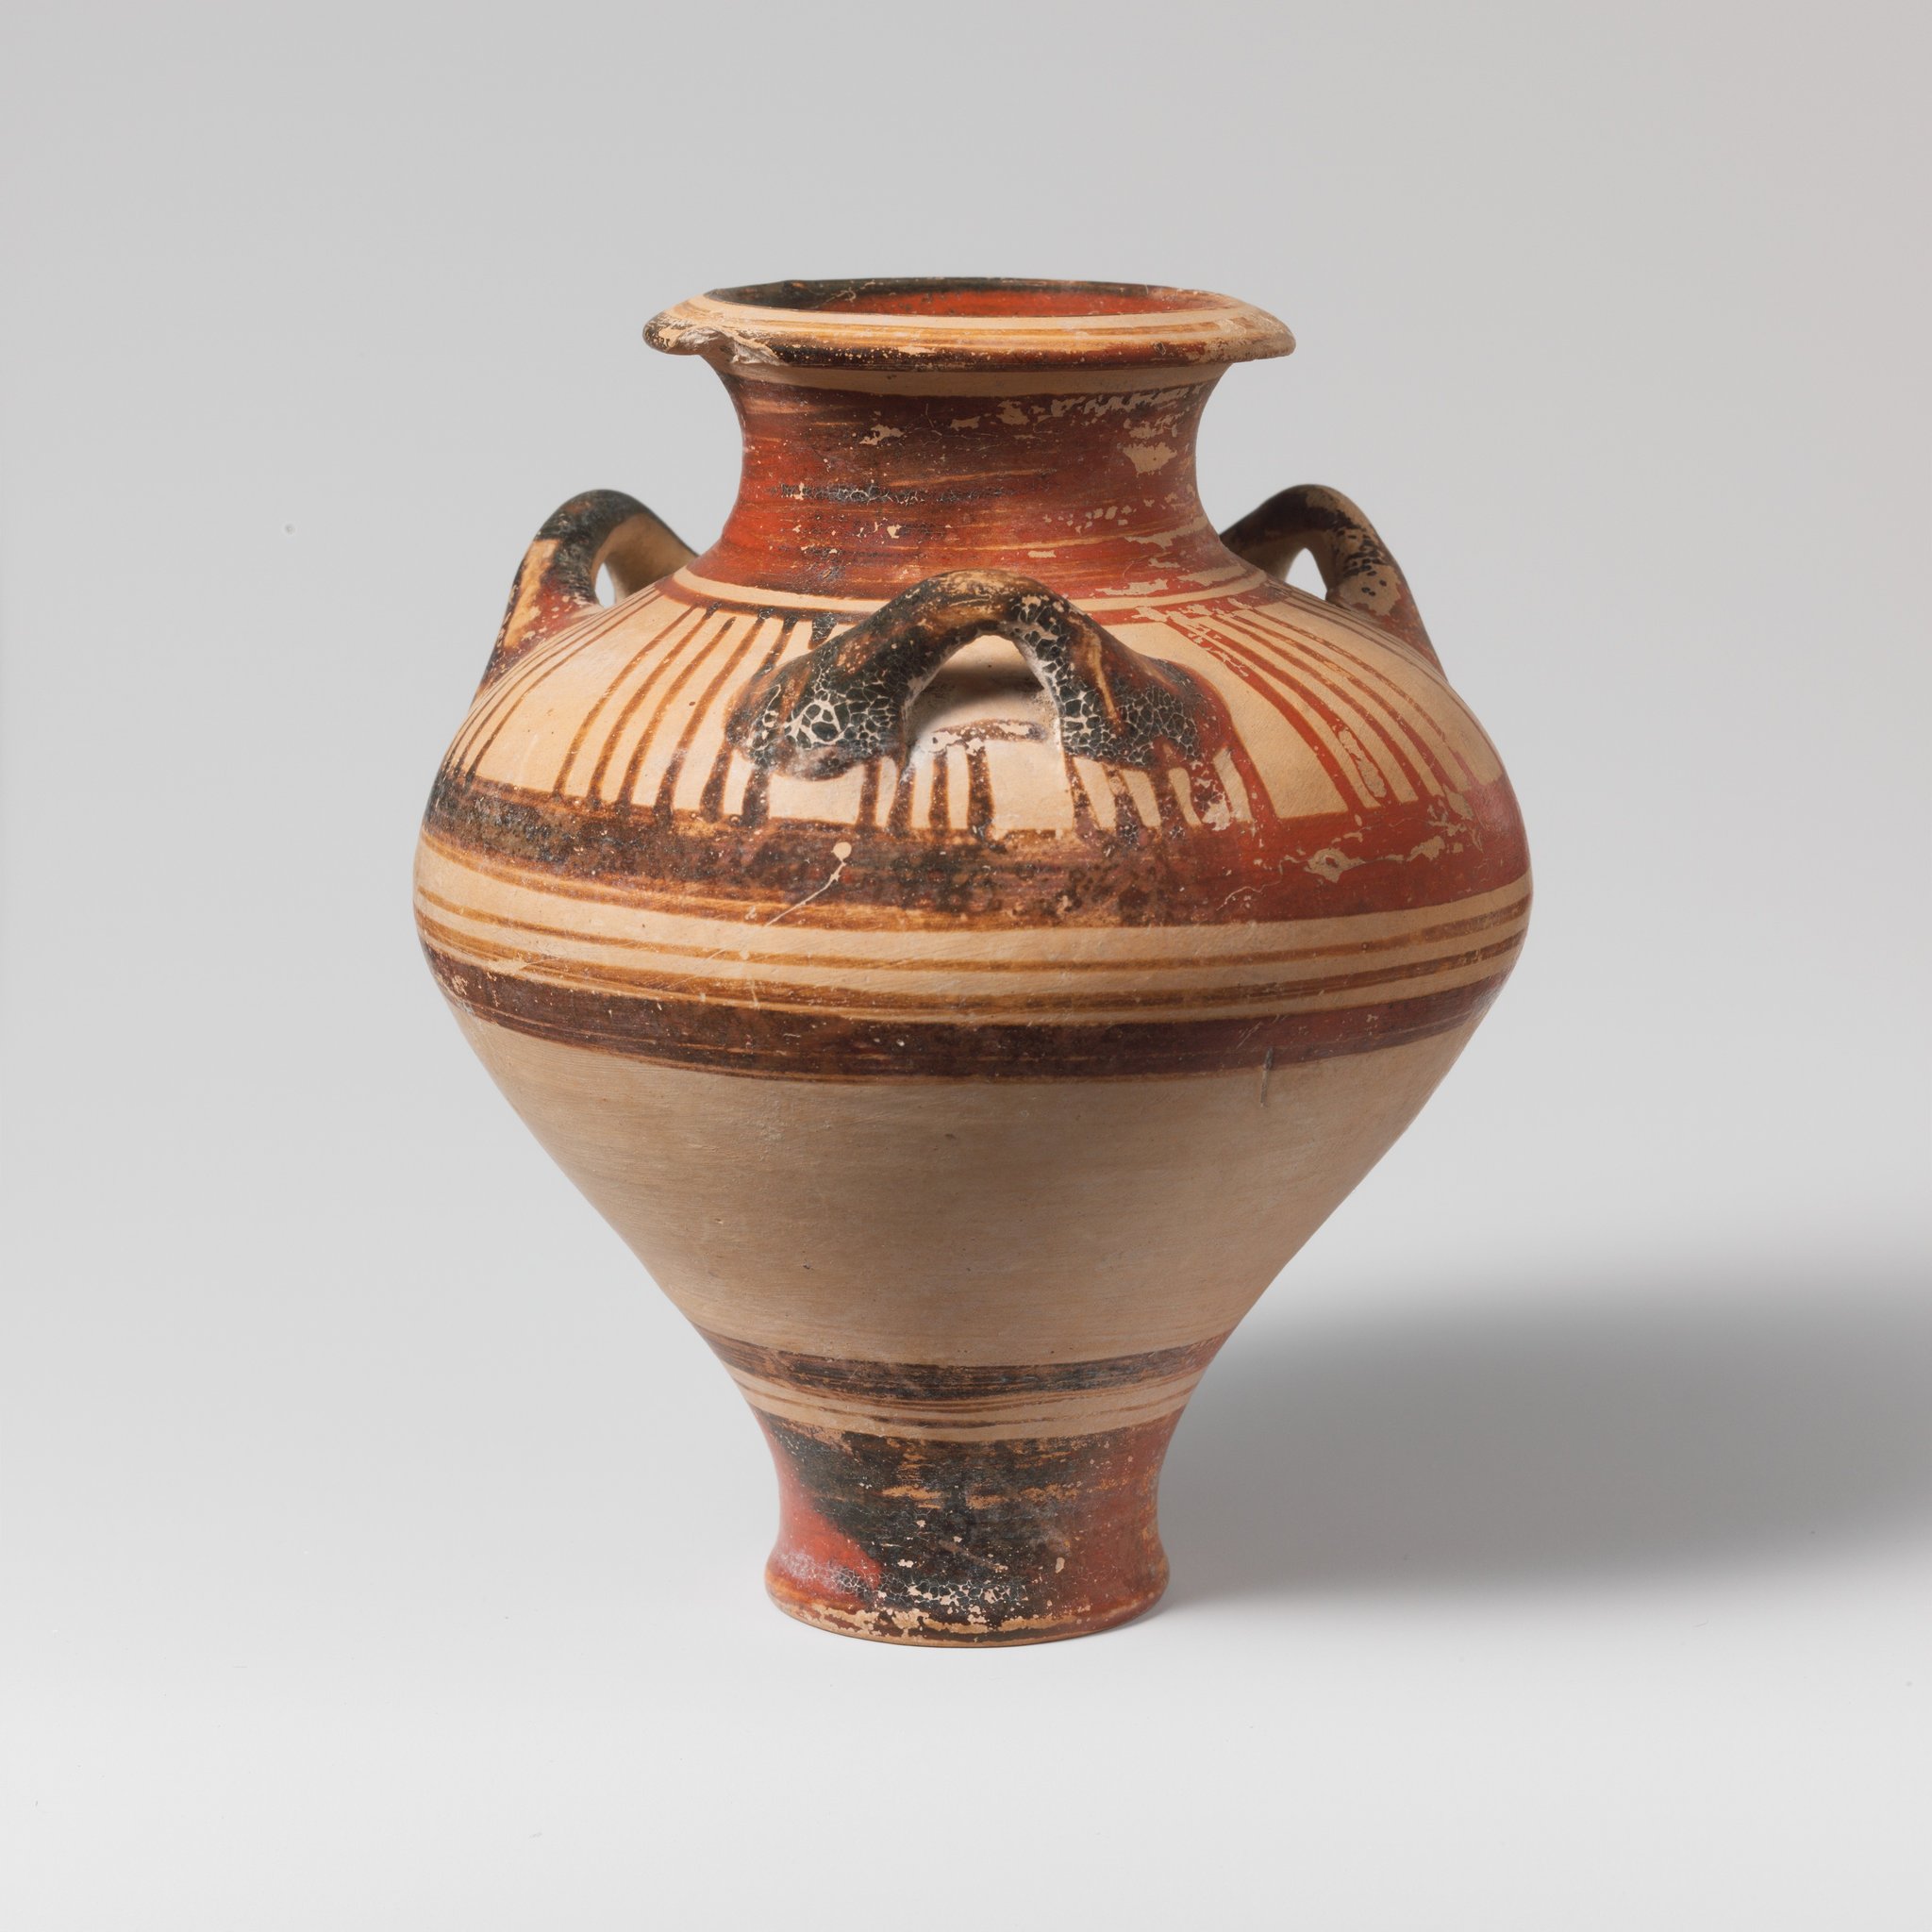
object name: vase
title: Terracotta pithoid jar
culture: mycenaean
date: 1400-1200 BCE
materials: terracotta